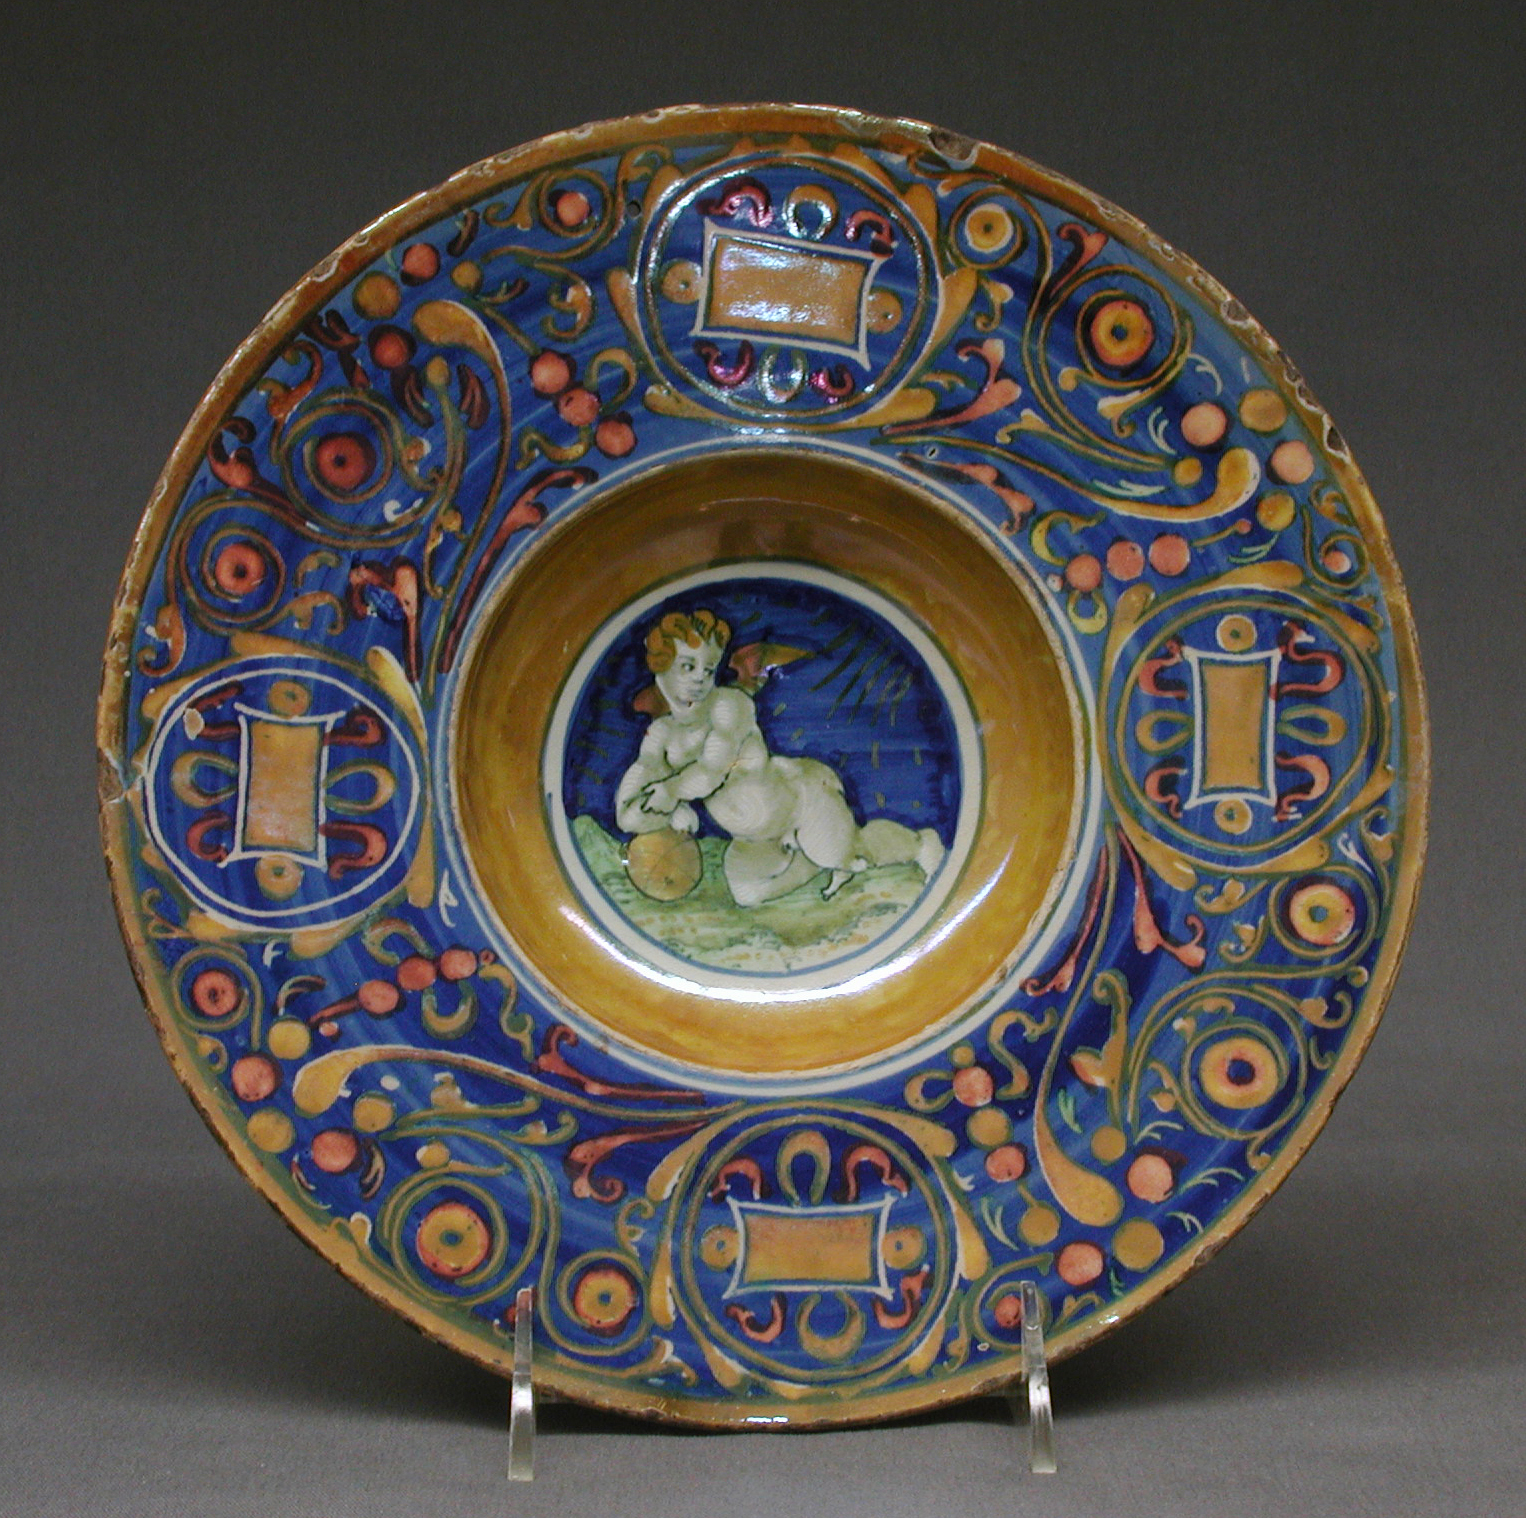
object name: plate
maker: maestro giorgio andreoli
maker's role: maker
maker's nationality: italian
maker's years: 1500-1550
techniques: maiolica, glazing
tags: cupid